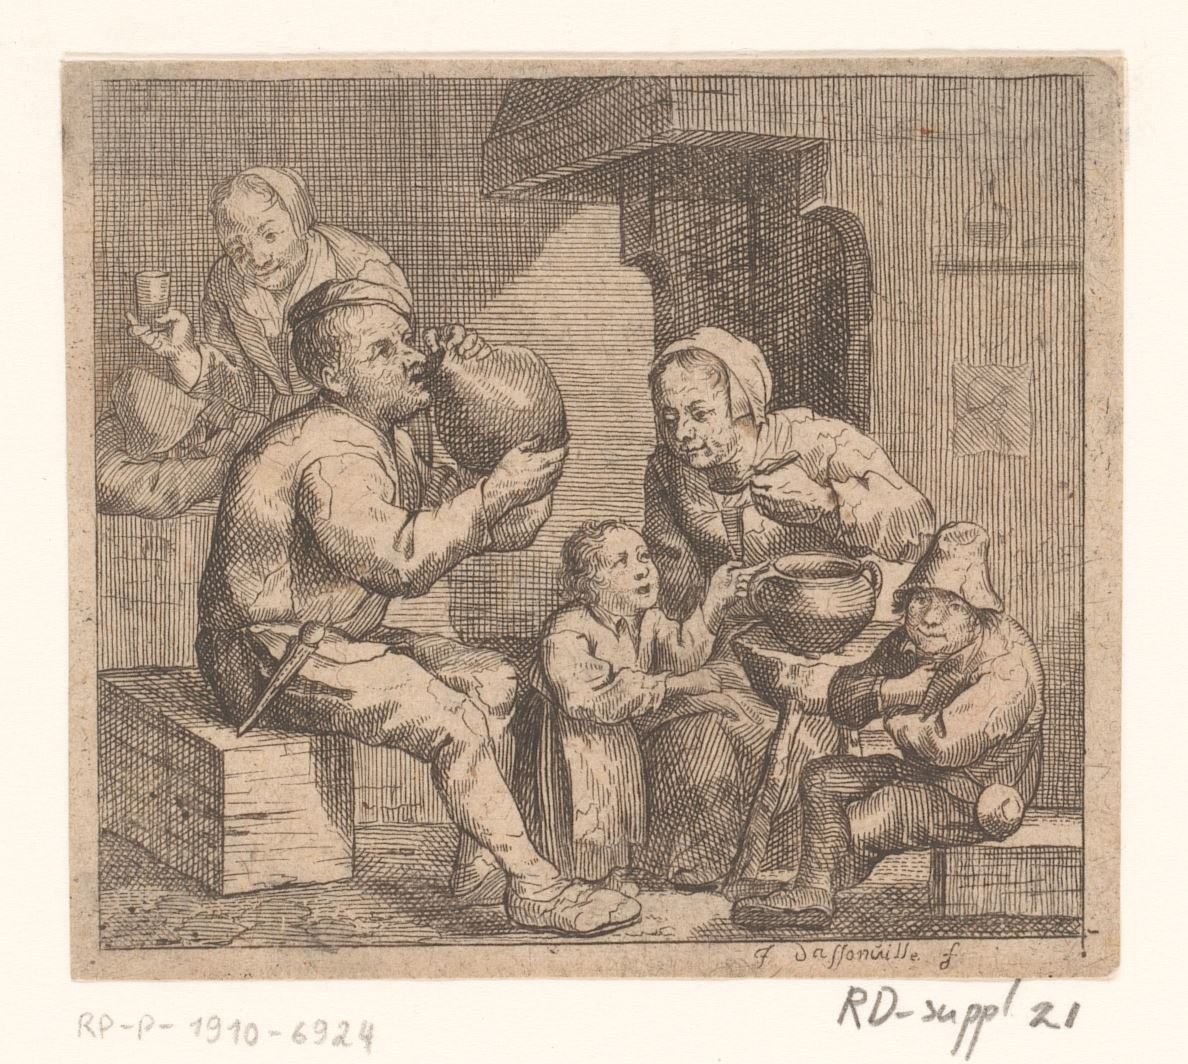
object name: print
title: Gezin voor de open haard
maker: jacques dassonville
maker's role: print maker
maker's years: 1619-1670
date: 1629-1670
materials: paper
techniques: engraving, etching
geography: france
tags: giving food, drinking, parents (first degree family relationships)